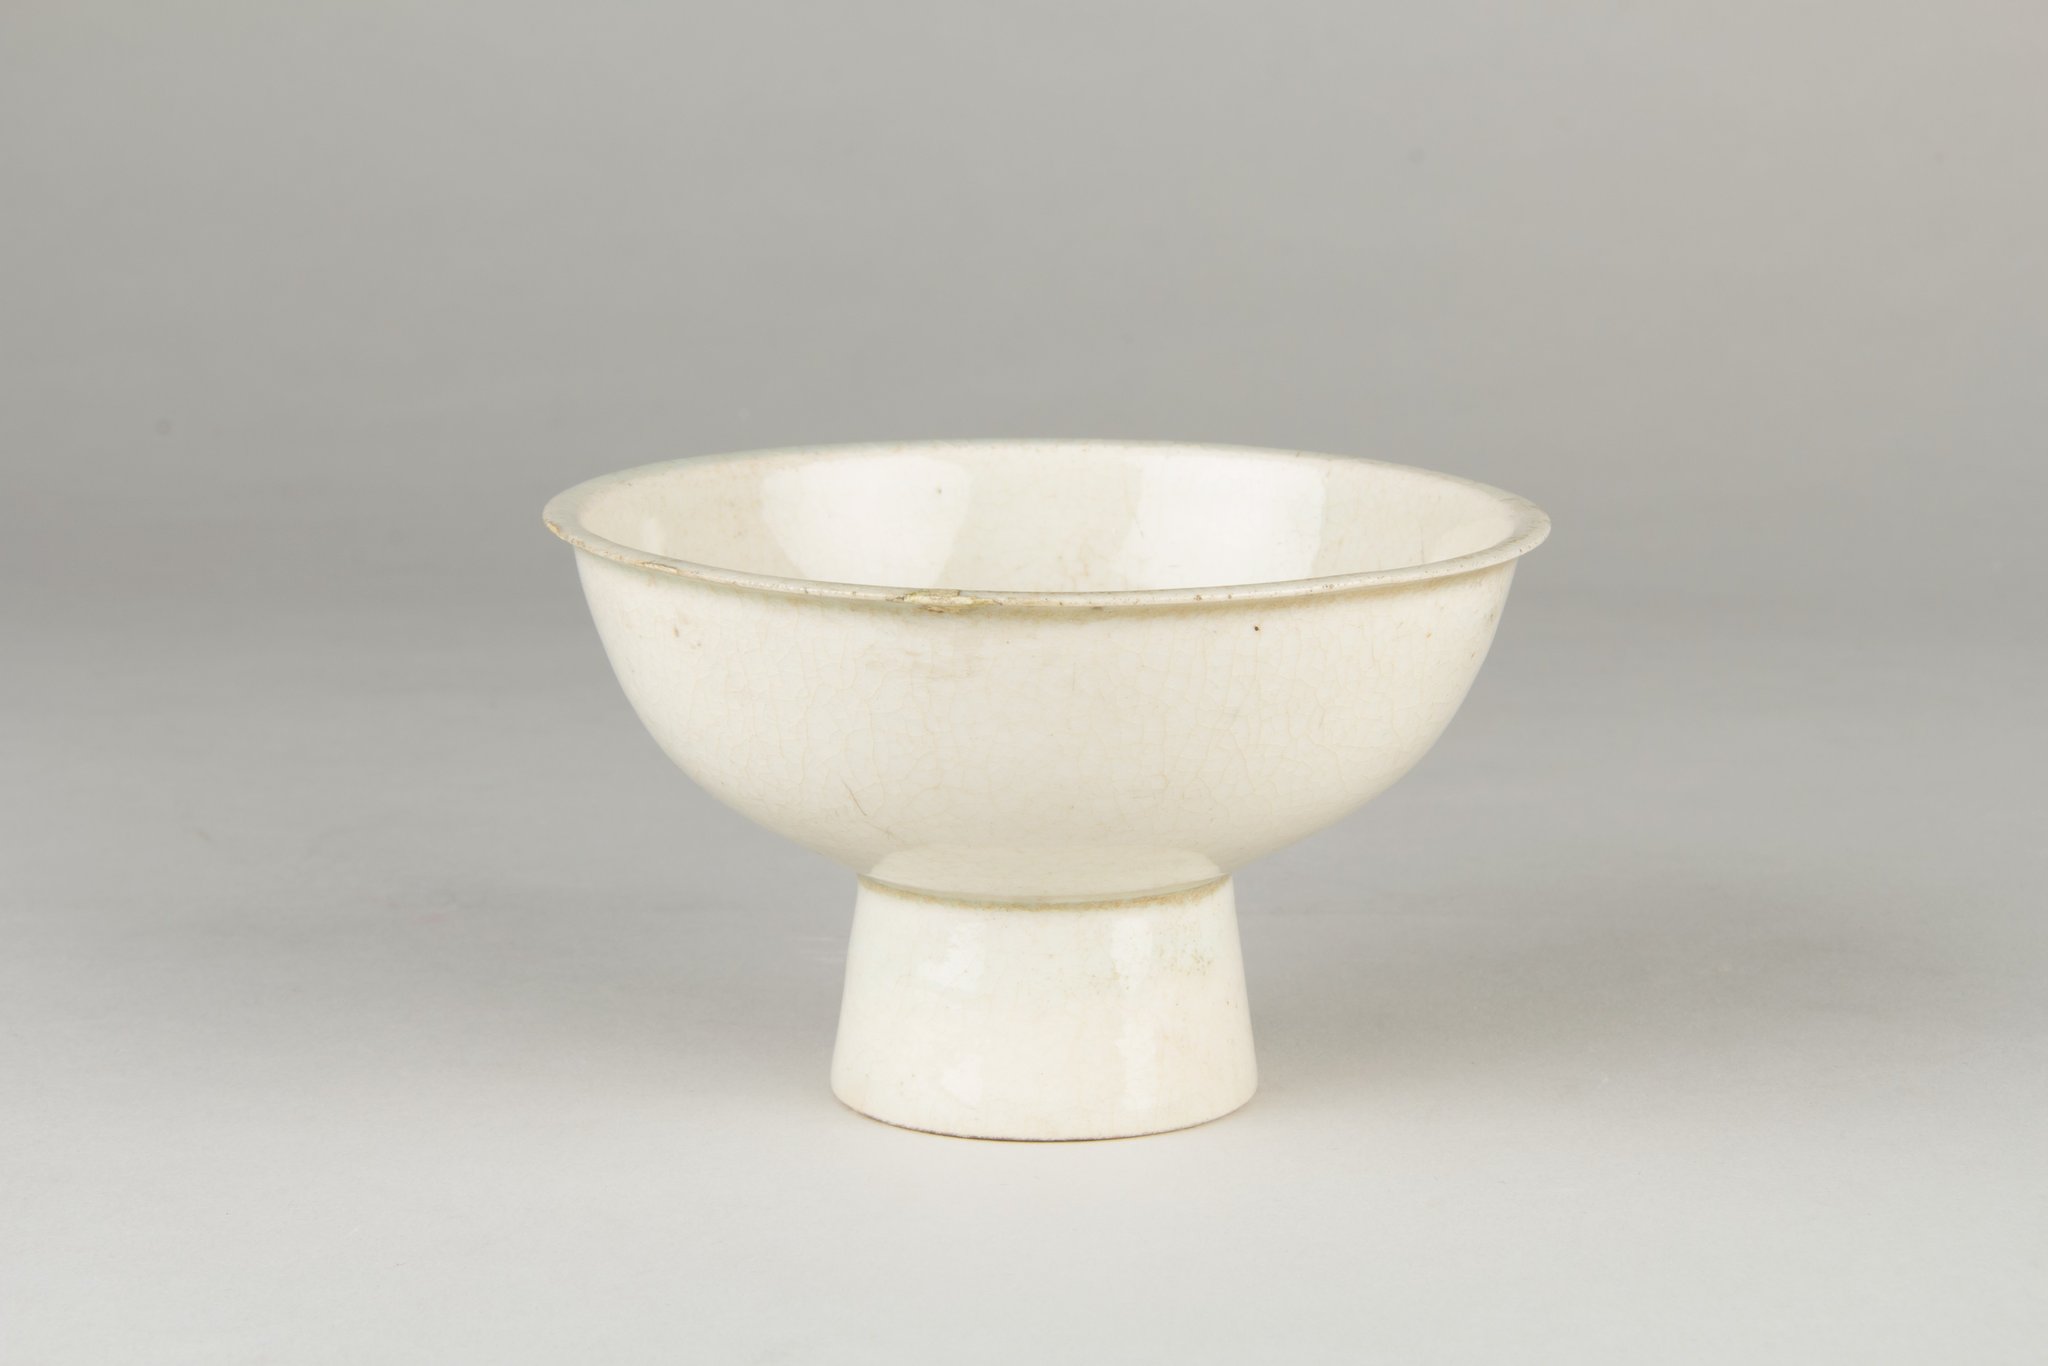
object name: vessel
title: Ritual vessel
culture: korean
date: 918-1392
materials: porcelain